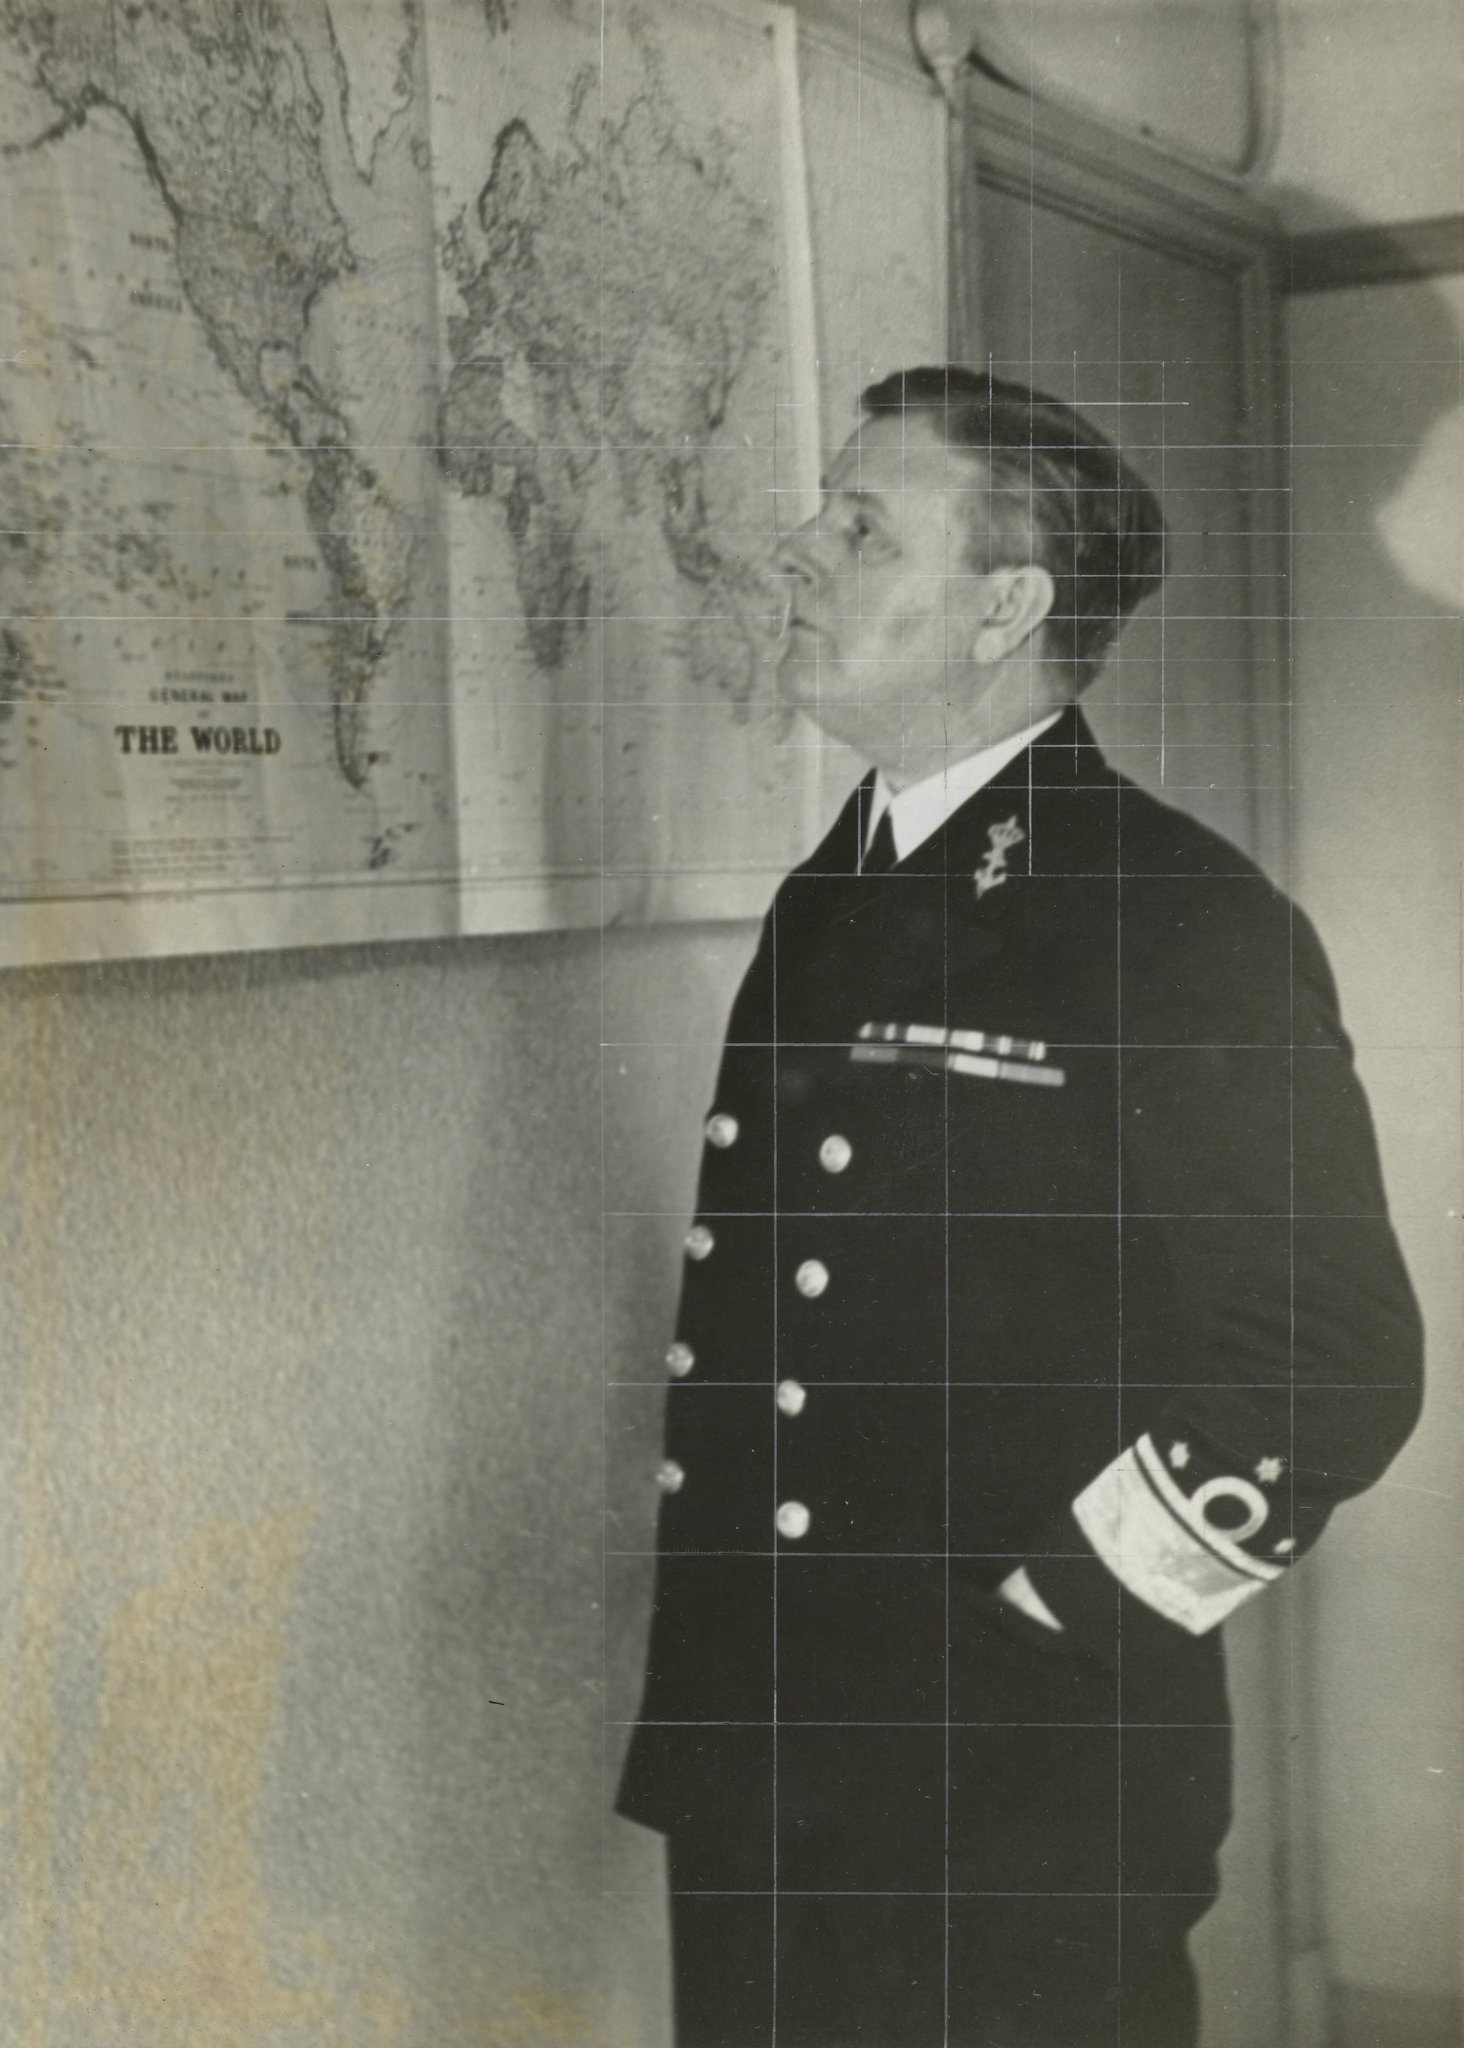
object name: photograph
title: Admiraal J. Th. Furstner, minister van Marine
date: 1940-1945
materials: photographic support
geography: london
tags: london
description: Admiraal J. Th. Furstner (1887-1970) , minister van Marine. Tijdens de Tweede Wereldoorlog combineerde hij het ministerschap van Marine met de functie van bevelhebber van de marine. Deze foto is door kunstenaar Cor Visser gebruikt voor het portret van het tweede kabinet Gerbrandy. Het lijnennet op de foto is door Cor Visser aangebracht.